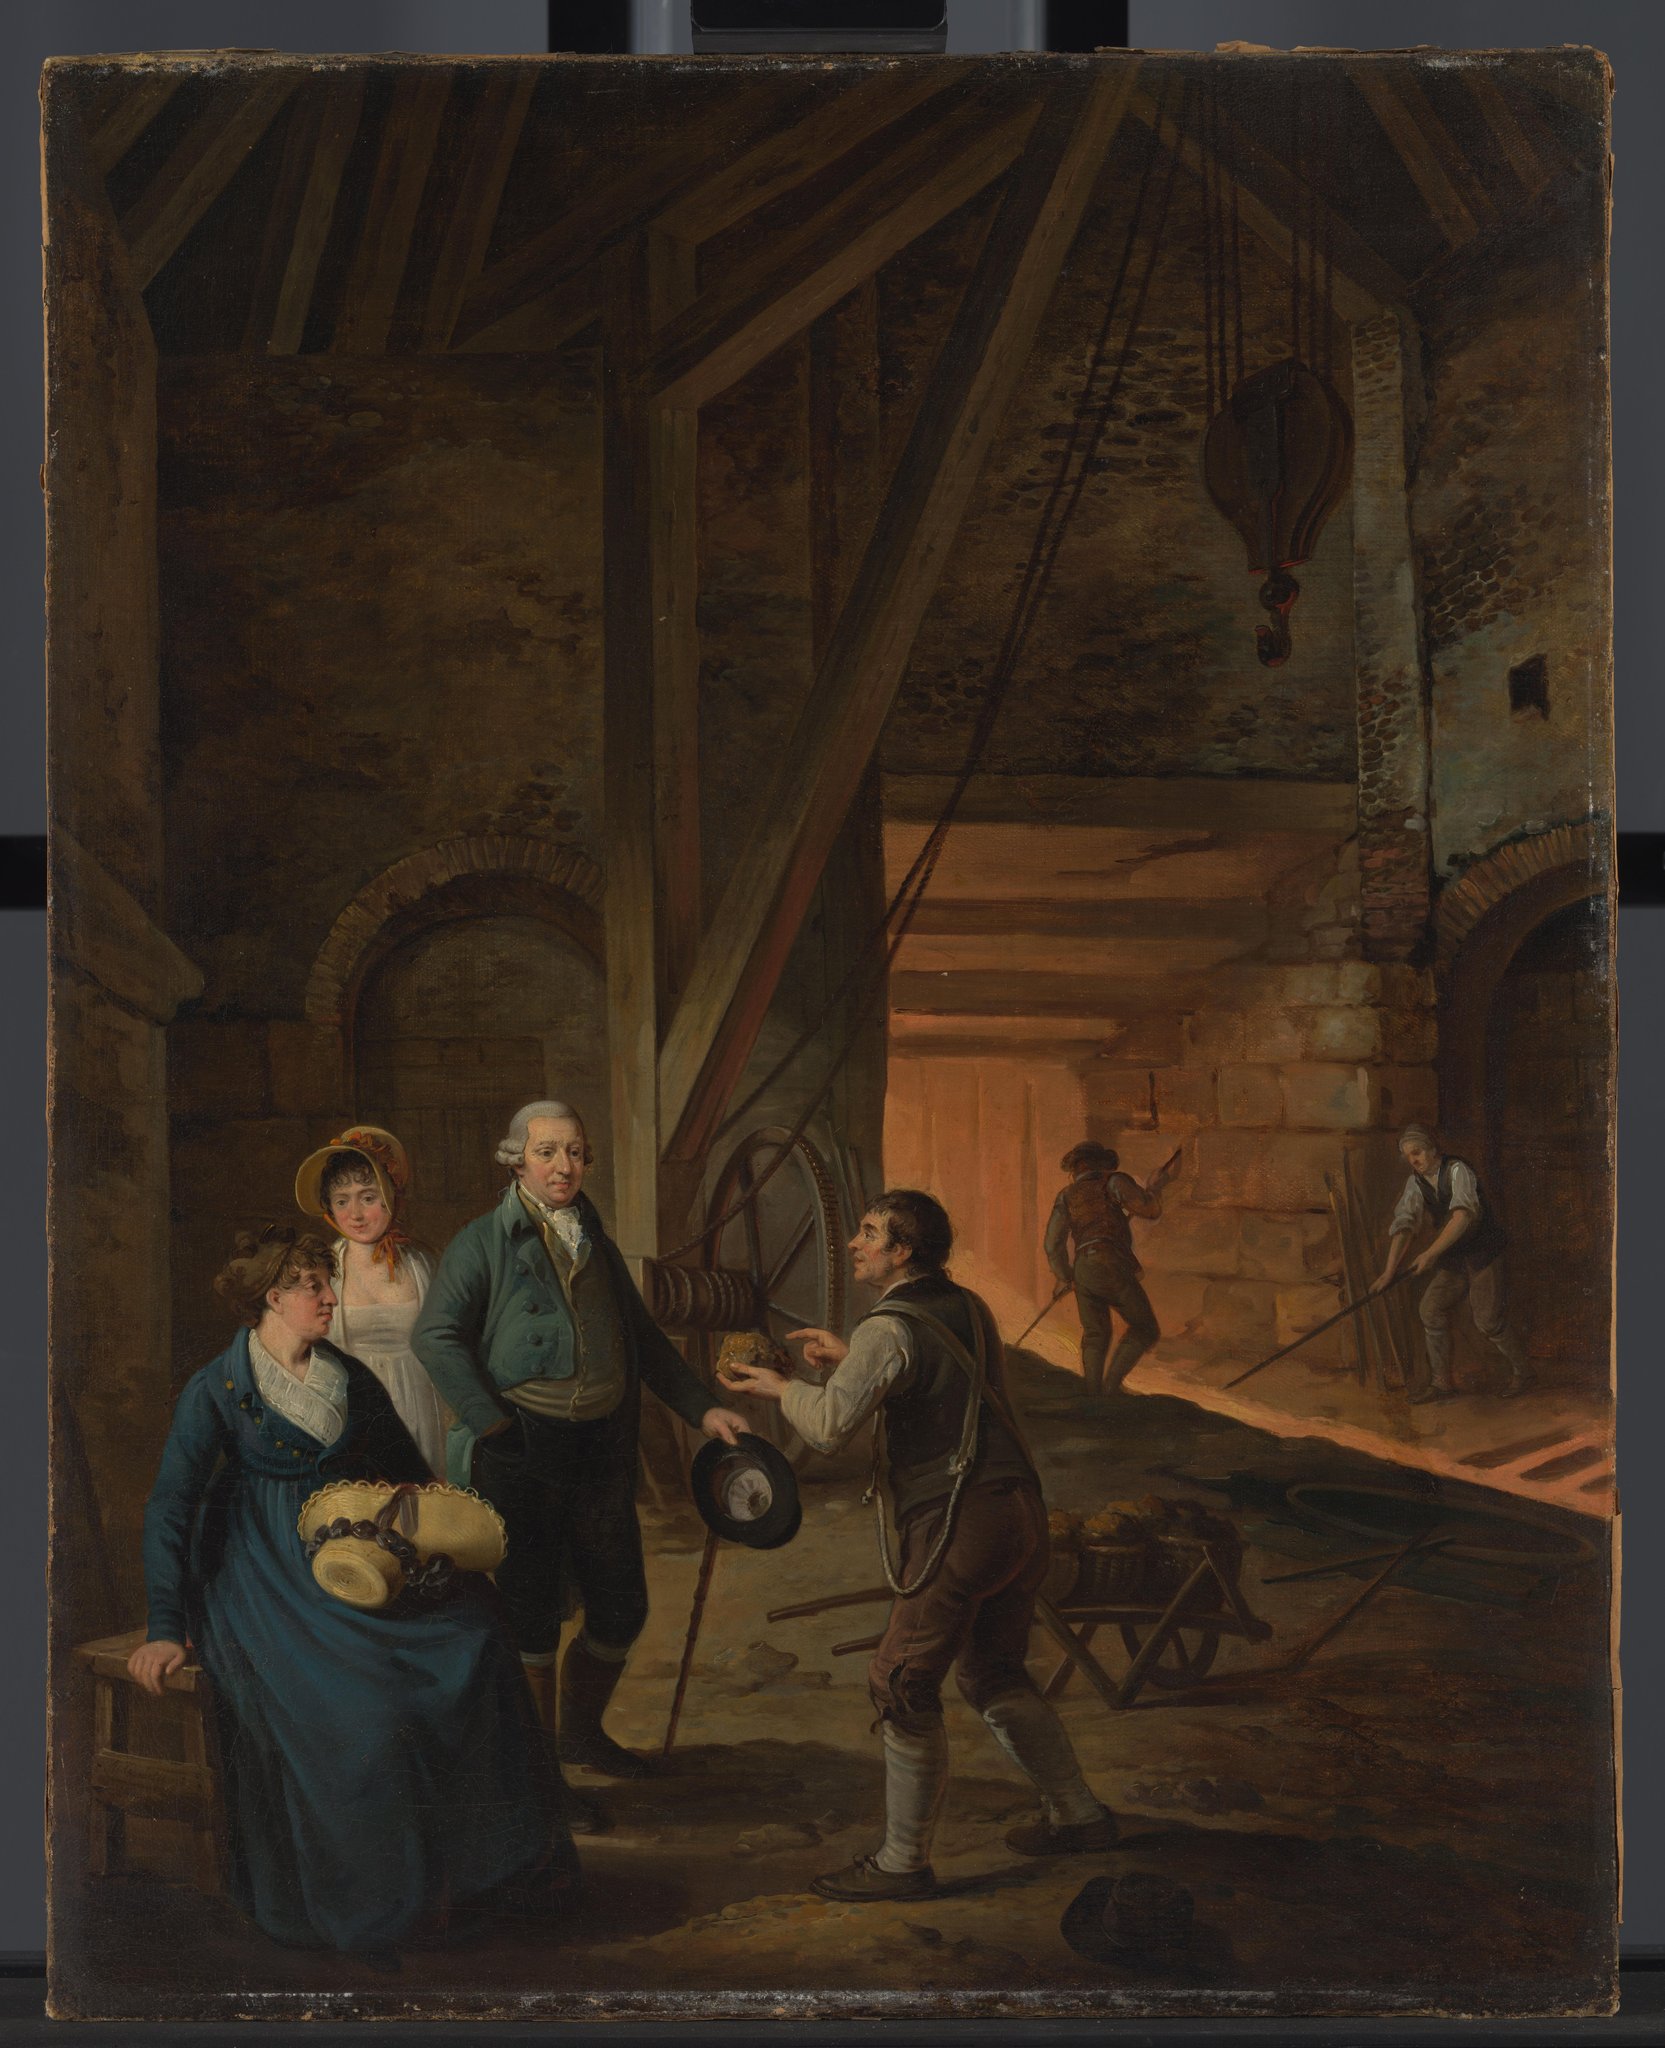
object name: painting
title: Jan Daniël Huichelbos van Liender, Petronella van Liender and Adriana Reepmaker in an English Iron Foundry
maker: adriaan de lelie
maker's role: draughtsman, painter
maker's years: 1755-1820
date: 1808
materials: canvas, oil, paint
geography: amsterdam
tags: adriana jacoba christina reepmaker, koopman, jan daniël huichelbos van liender, petronella huichelbos van liender, shropshire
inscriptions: signature and date: ‘A. de Lelie ft/Ao 1808.’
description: While wind and water were still the primary sources of energy in the Netherlands, the Rotterdam merchant Huichelbos van Liender visited this English iron foundry to see inventor James Watt’s steam engine in operation. A worker shows him, in the company of his half-sister and a family friend, a piece of iron ore or coal. Van Liender became Watt’s Dutch representative and a driving force behind the introduction of steam power in his homeland.